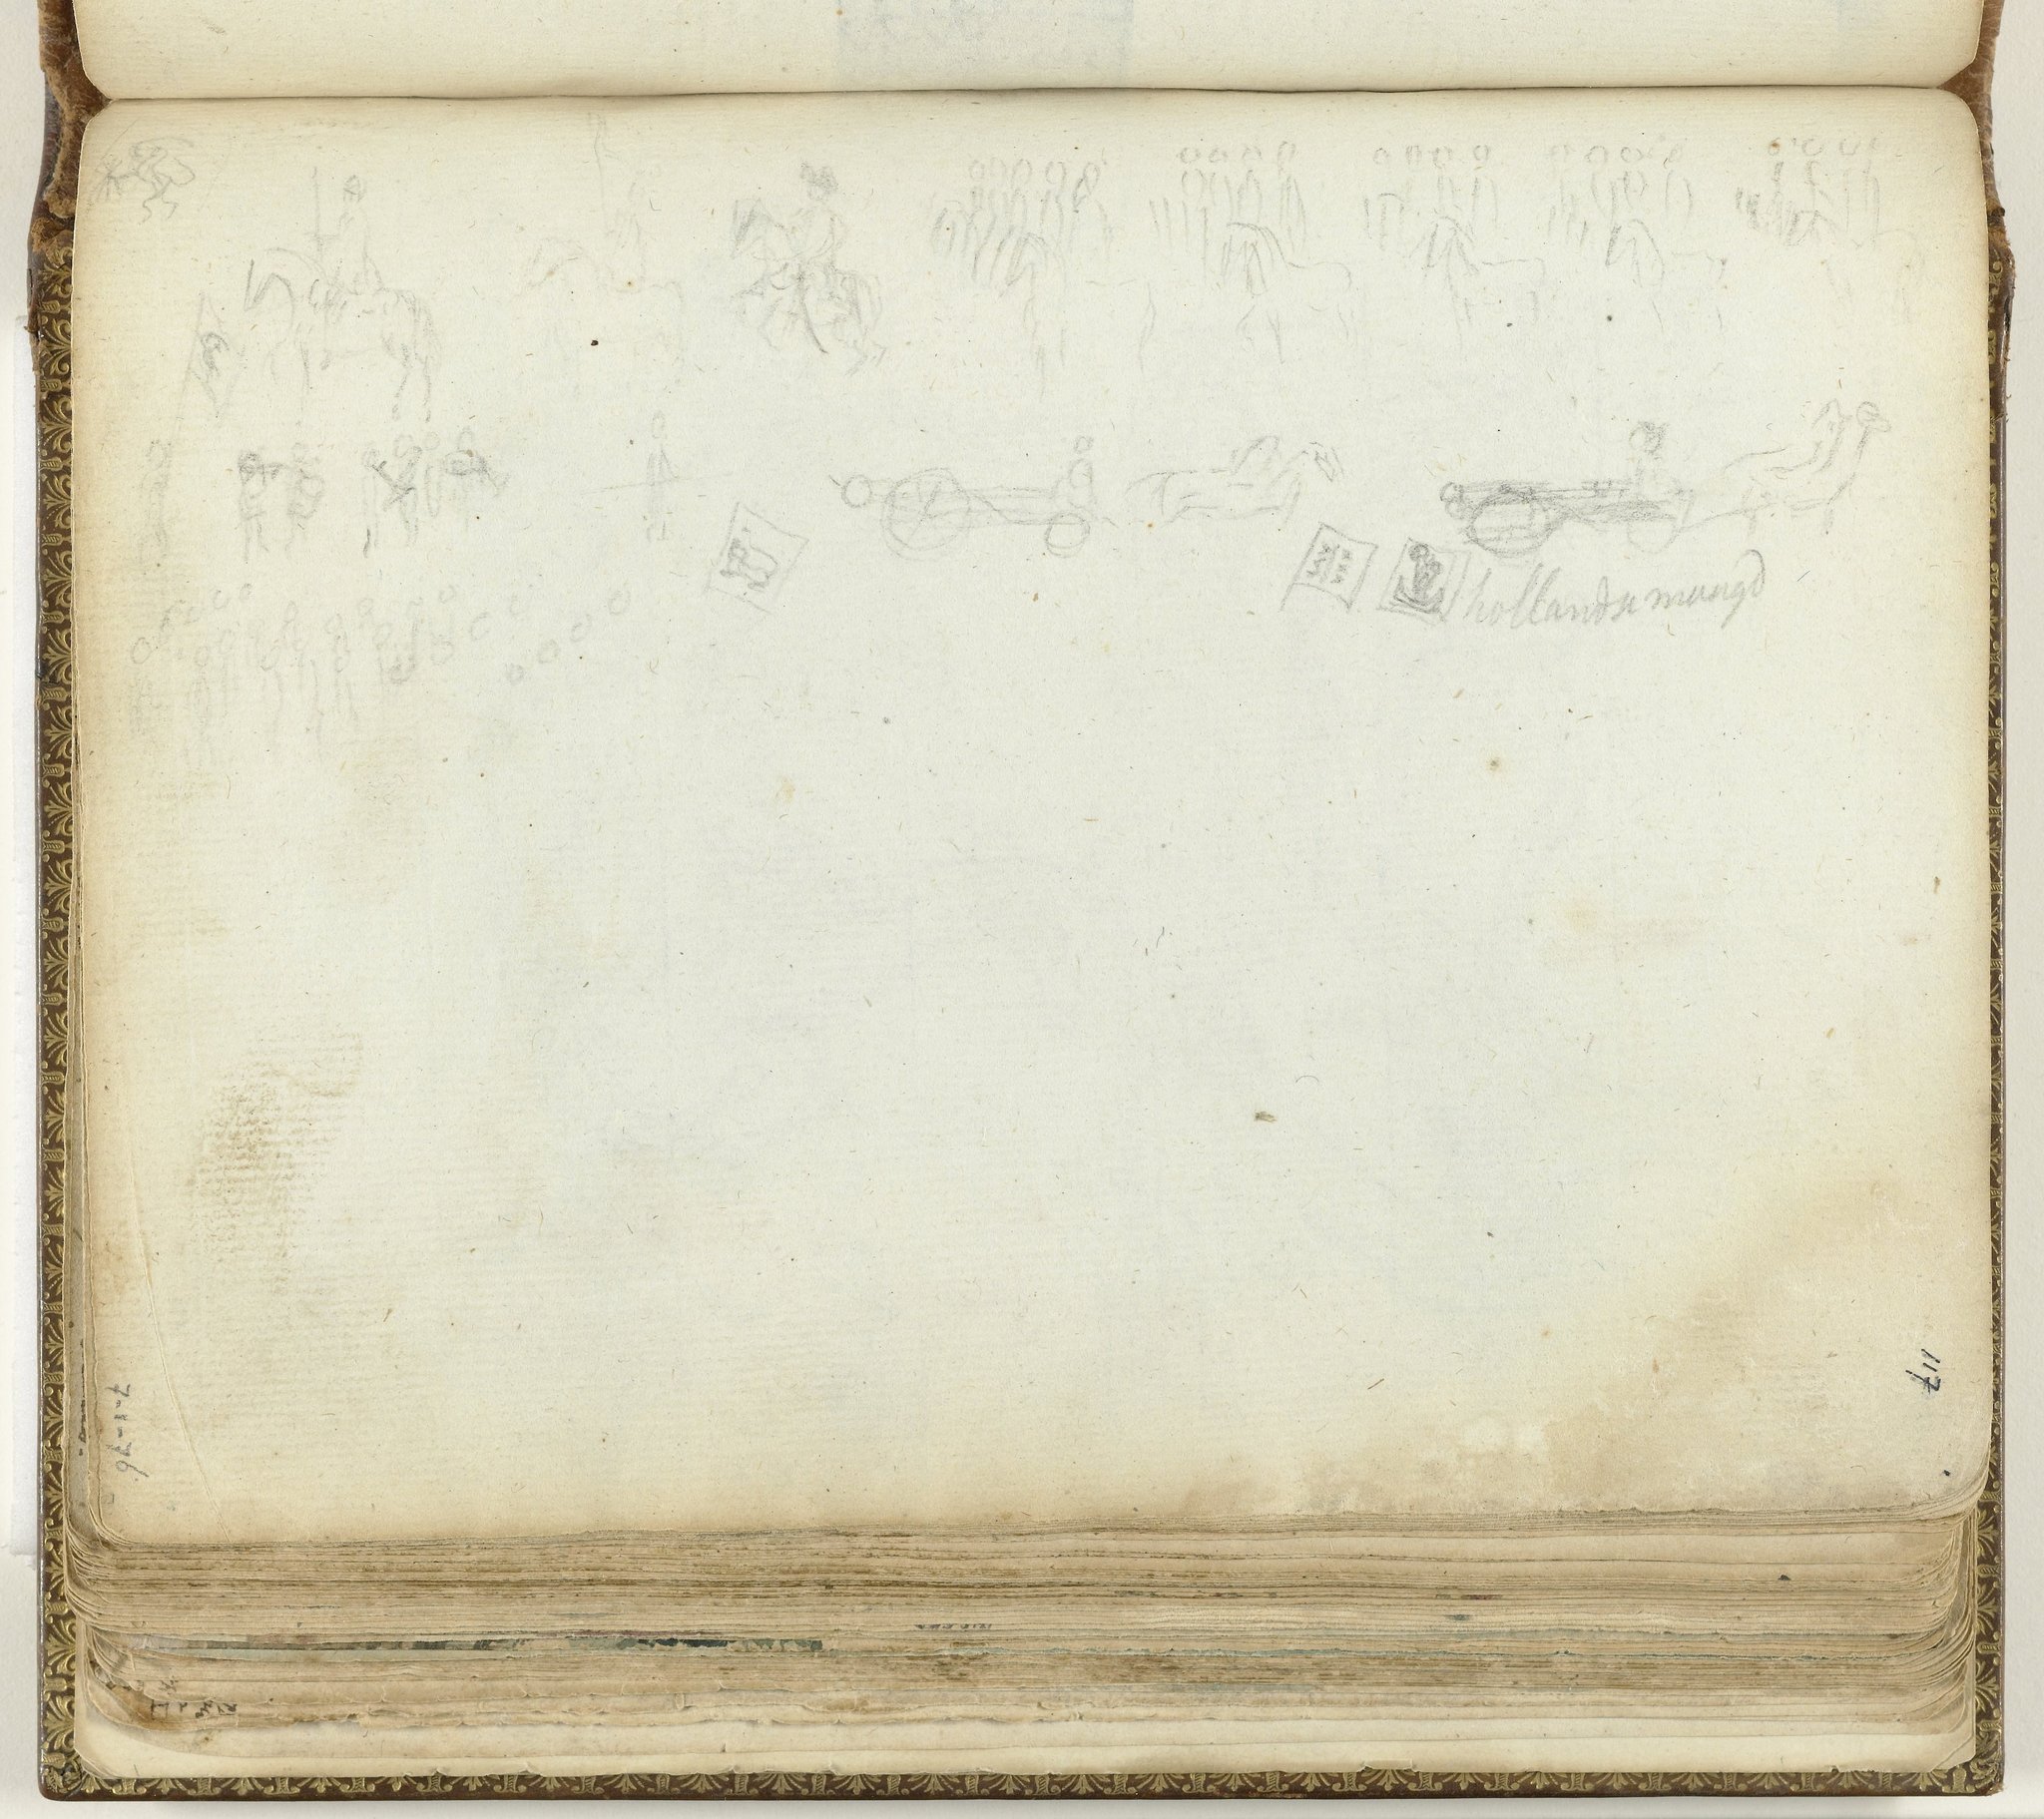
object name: drawing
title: Parade met wagens en ruiters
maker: jan brandes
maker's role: draughtsman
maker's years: 1743-1808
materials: paper, pencil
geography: netherlands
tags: military parade, pageant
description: Potloodschets van een optocht of begrafenisstoet. Het opschrift 'hollandsche maagd' duidt op politieke bijbedoelingen. Onderdeel uit het schetsboek van Jan Brandes, dl. 1 (1808), p. 117.